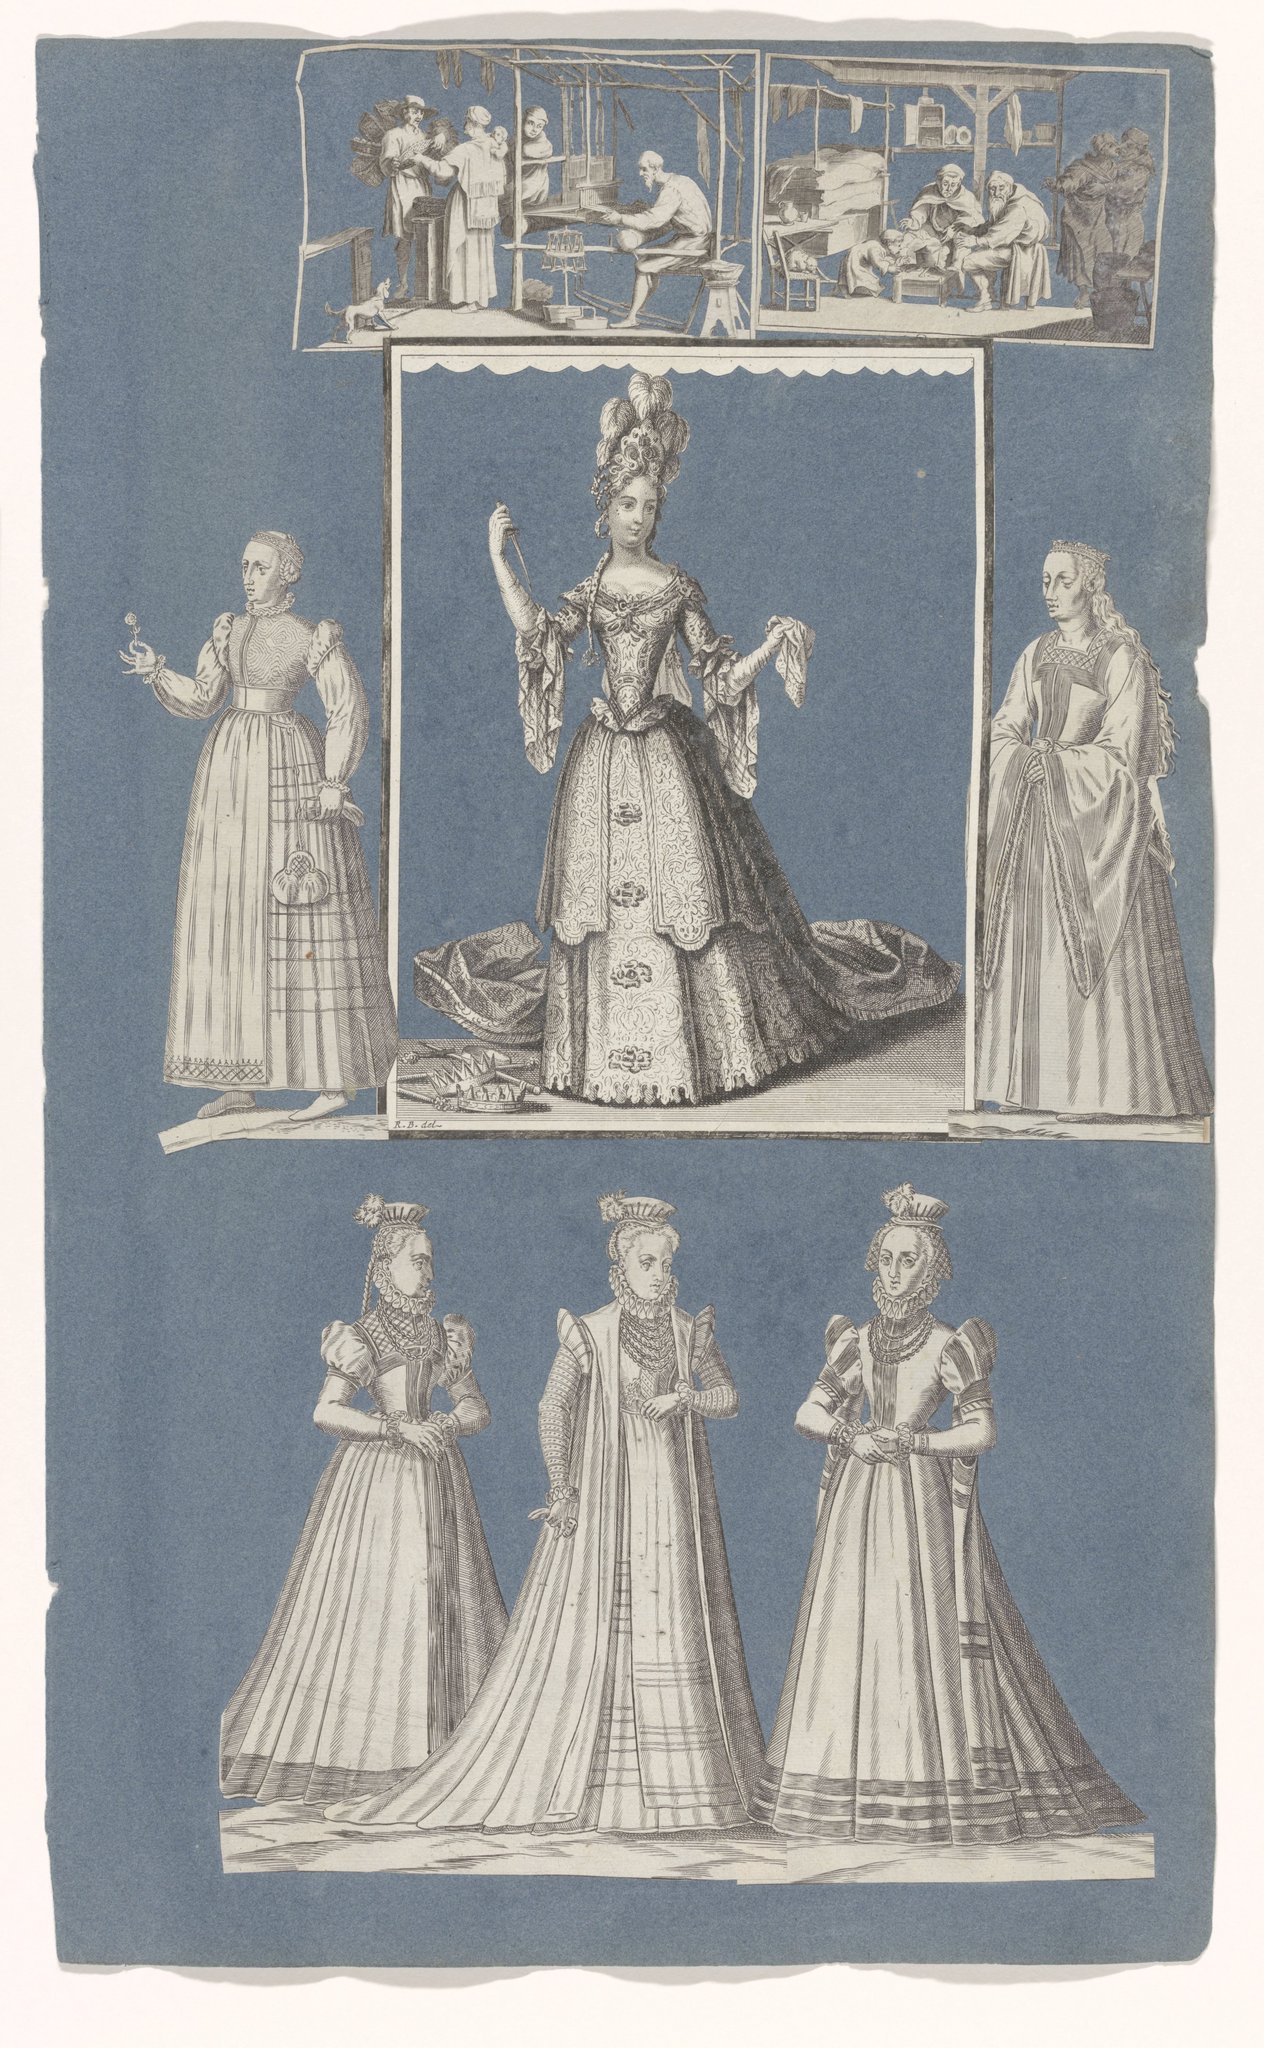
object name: print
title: Collage van uitgeknipte prenten geplakt op albumblad van blauw papier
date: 1585-1700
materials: paper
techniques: collage